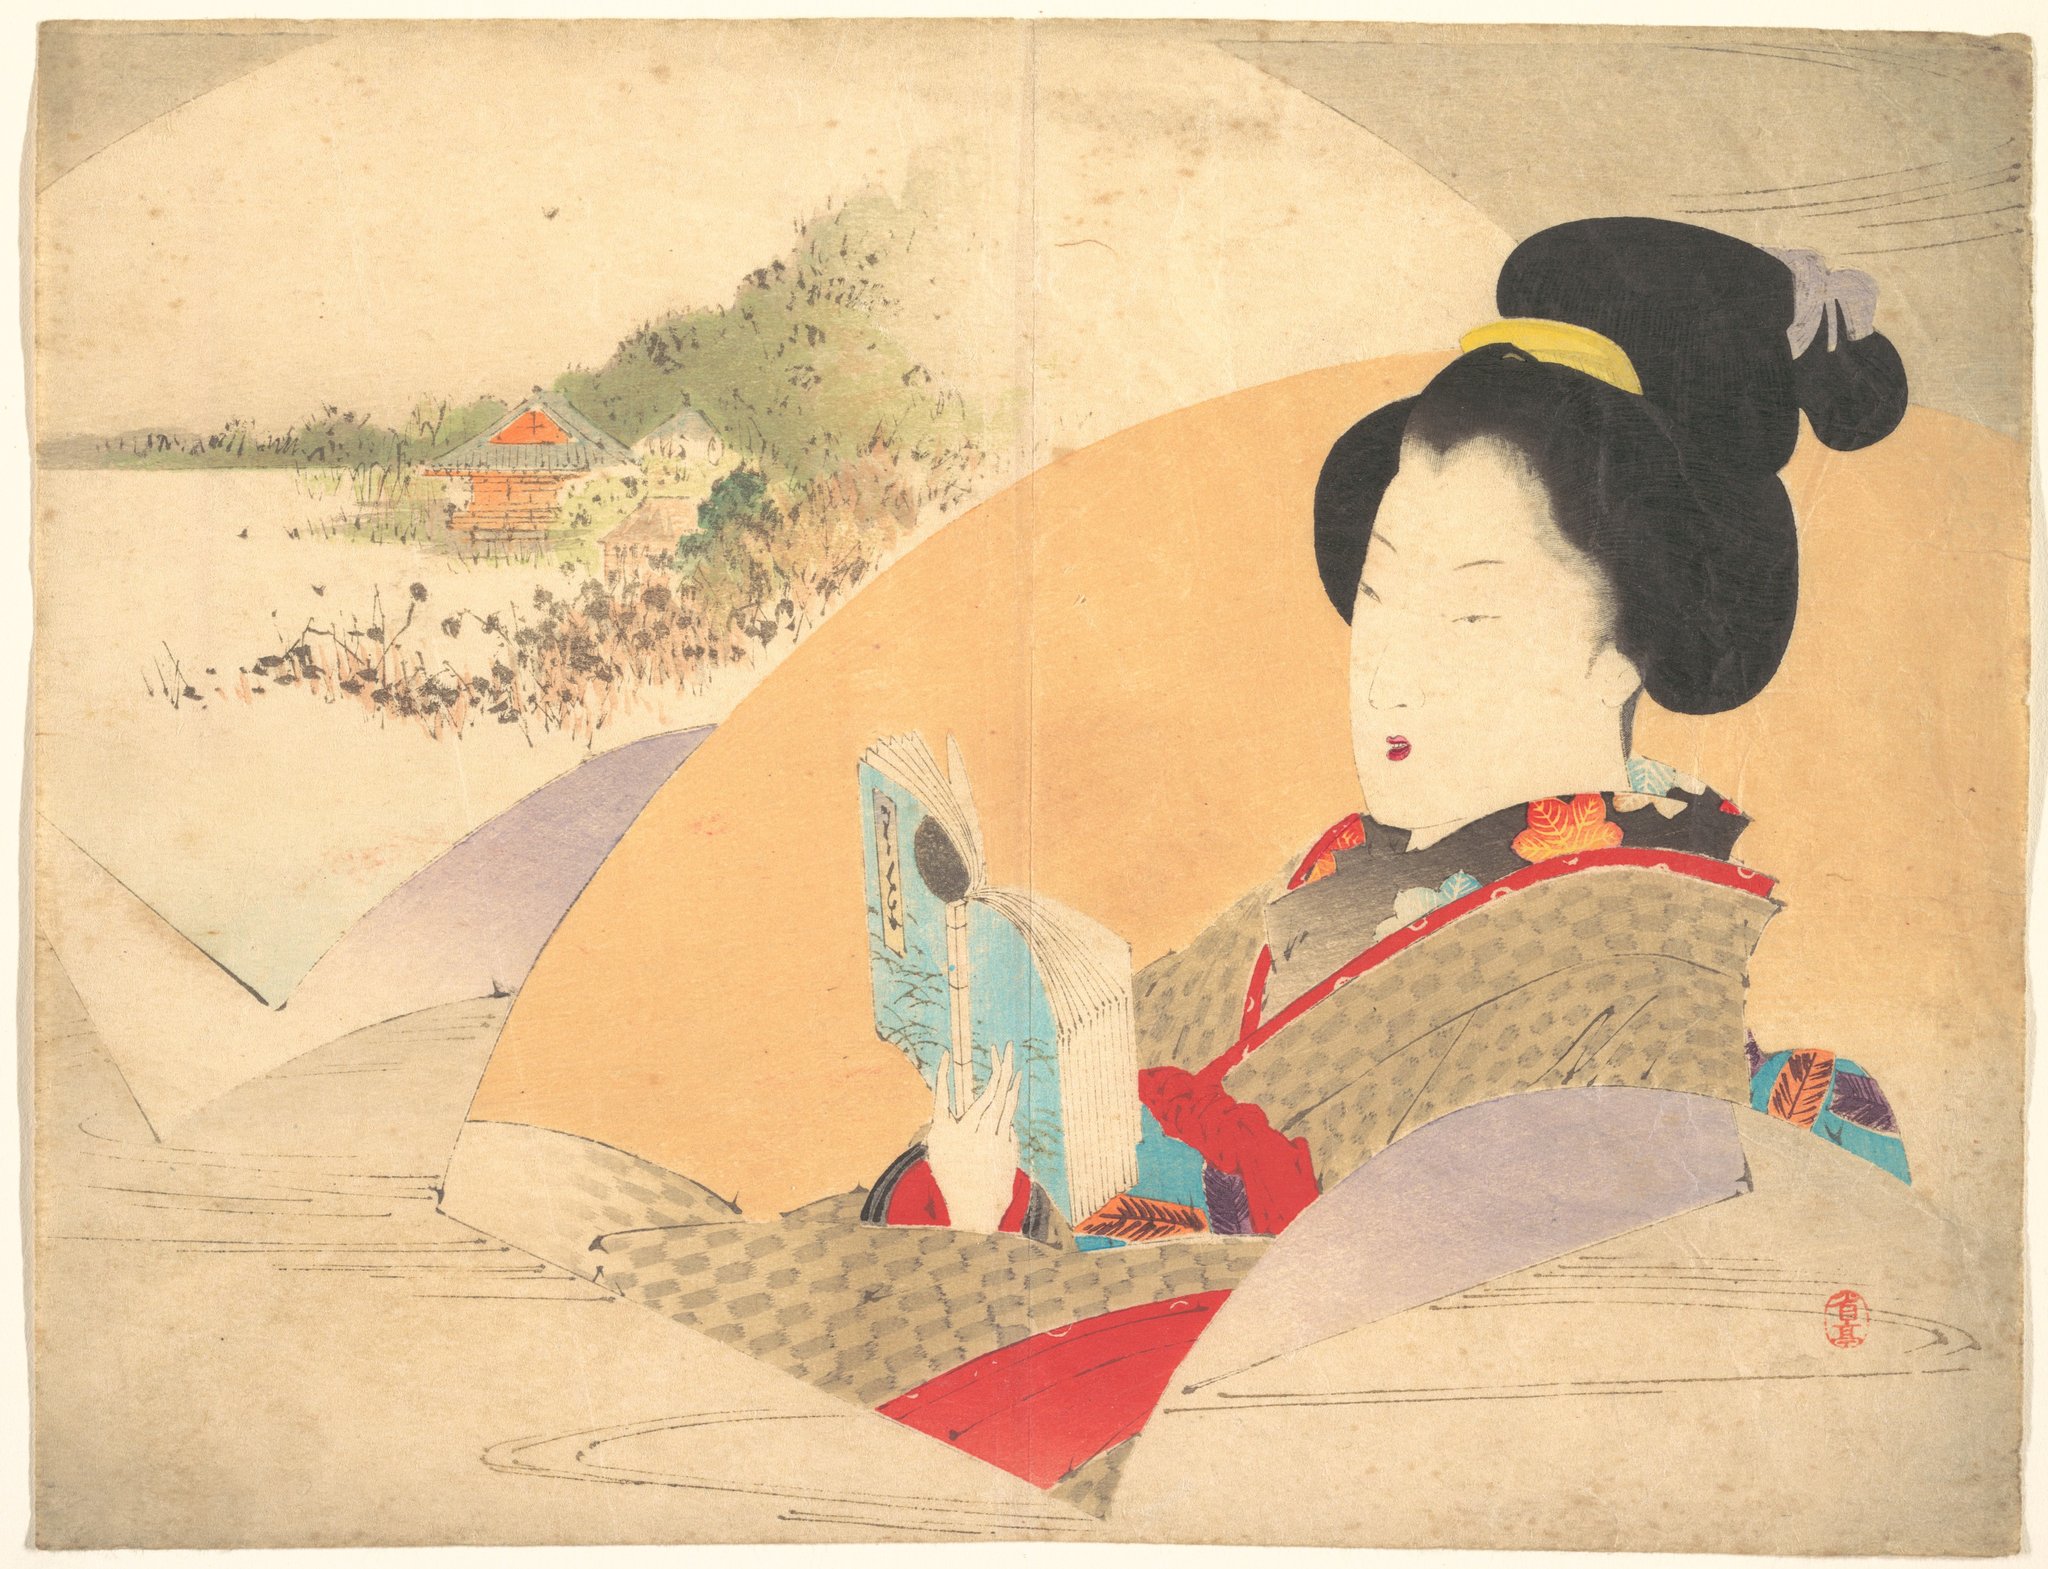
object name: print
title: Beauty Looking at Shinobazu Pond", illustration from Bugei Kurabu (Literary Club)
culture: japanese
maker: watanabe seitei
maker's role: artist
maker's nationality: japanese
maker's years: 1851-1918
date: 1906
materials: ink, paper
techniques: woodblock print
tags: books,women,reading